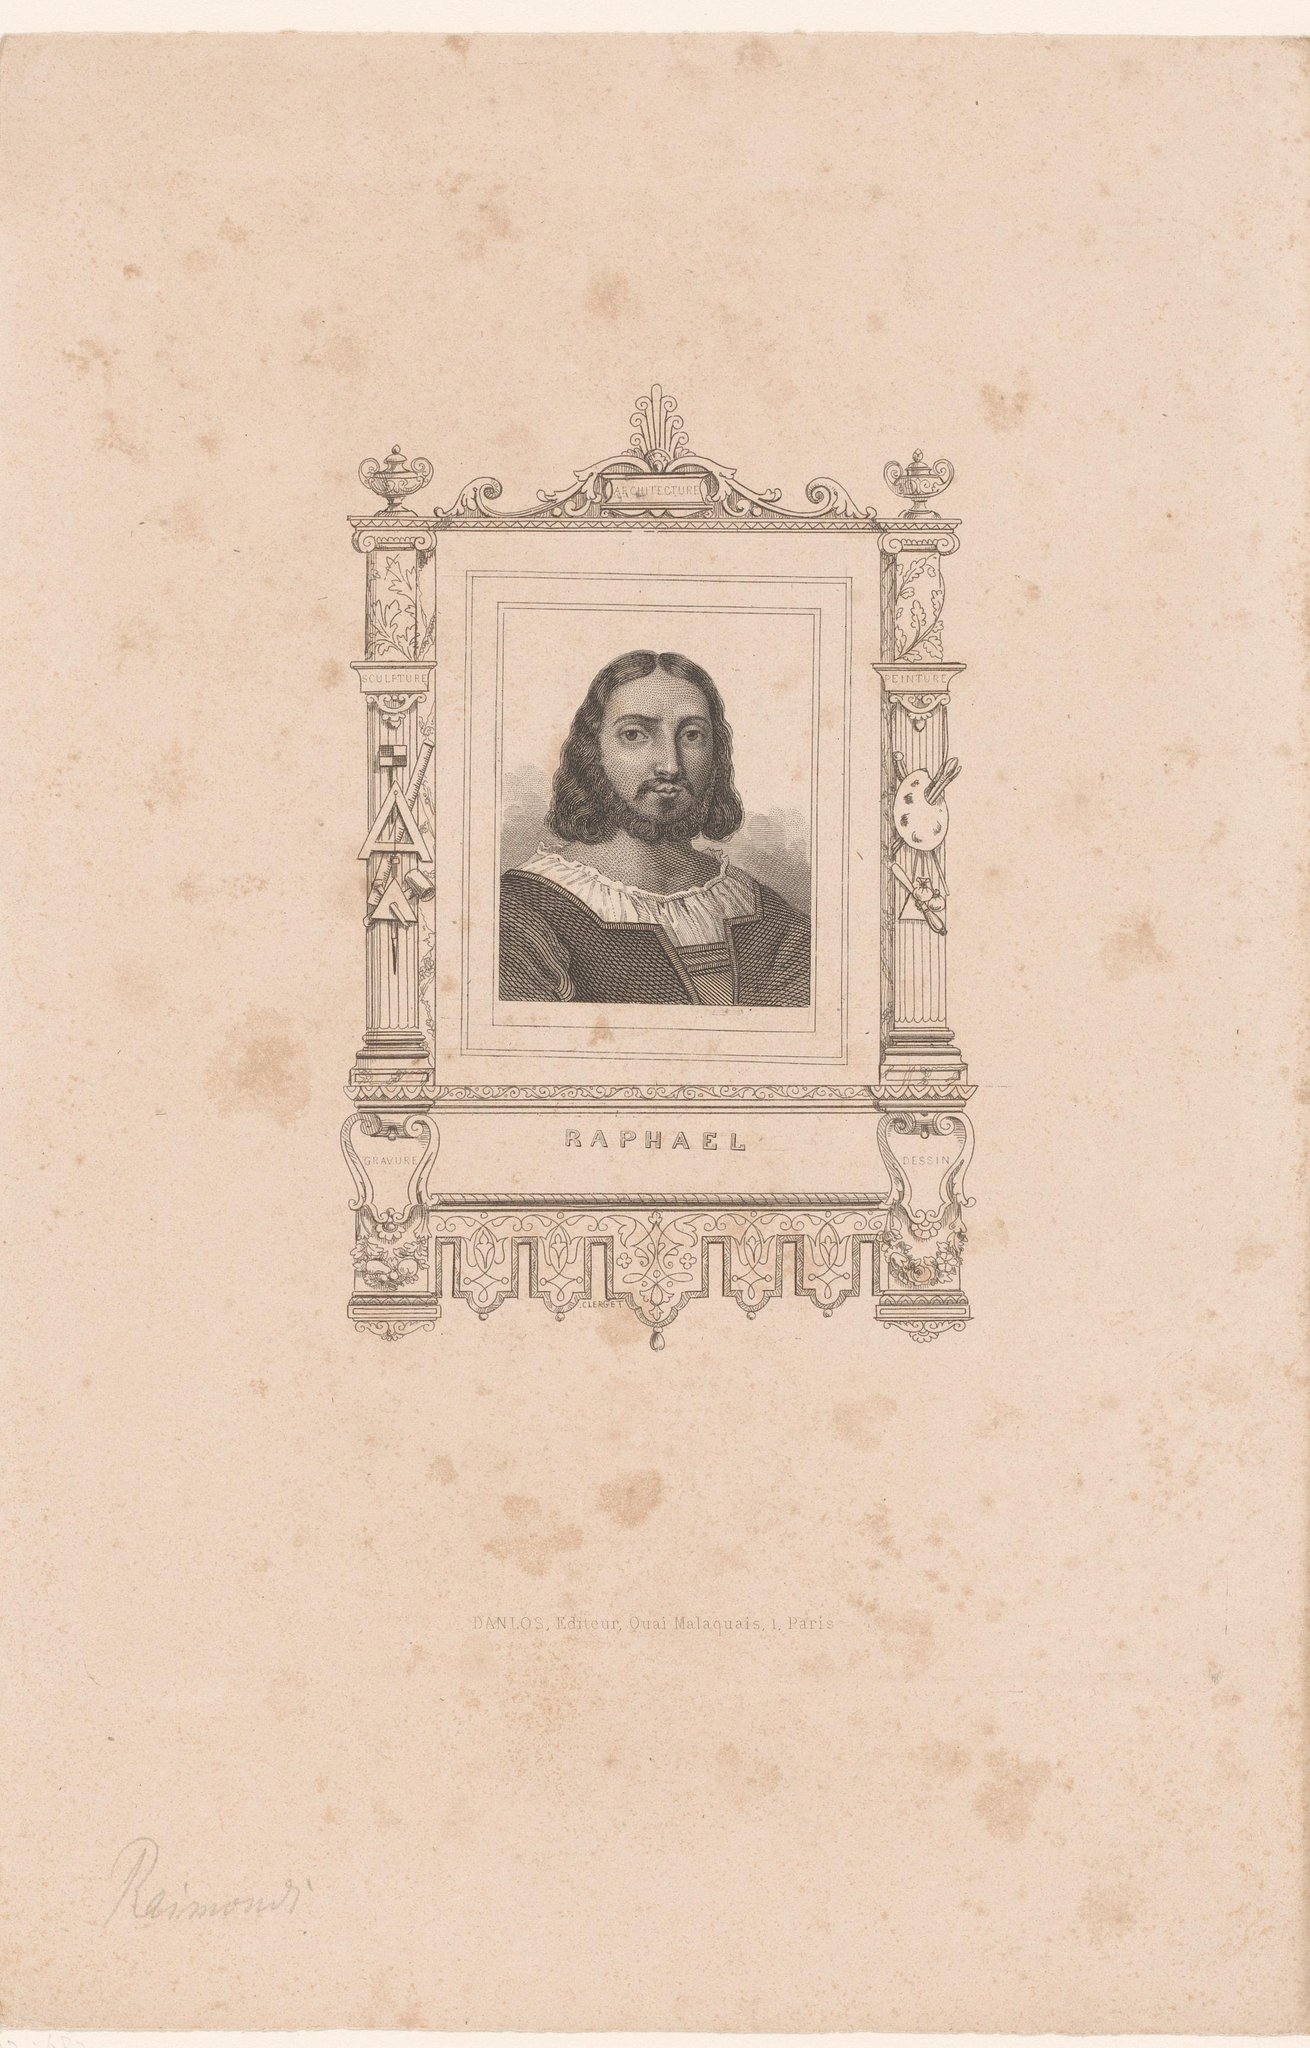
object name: print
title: Raphael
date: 1822-1870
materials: paper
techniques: etching, engraving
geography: france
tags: rome, painter, rafaël, historical persons, ornament ~ cartouche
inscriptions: collector's mark: Lugt 2228